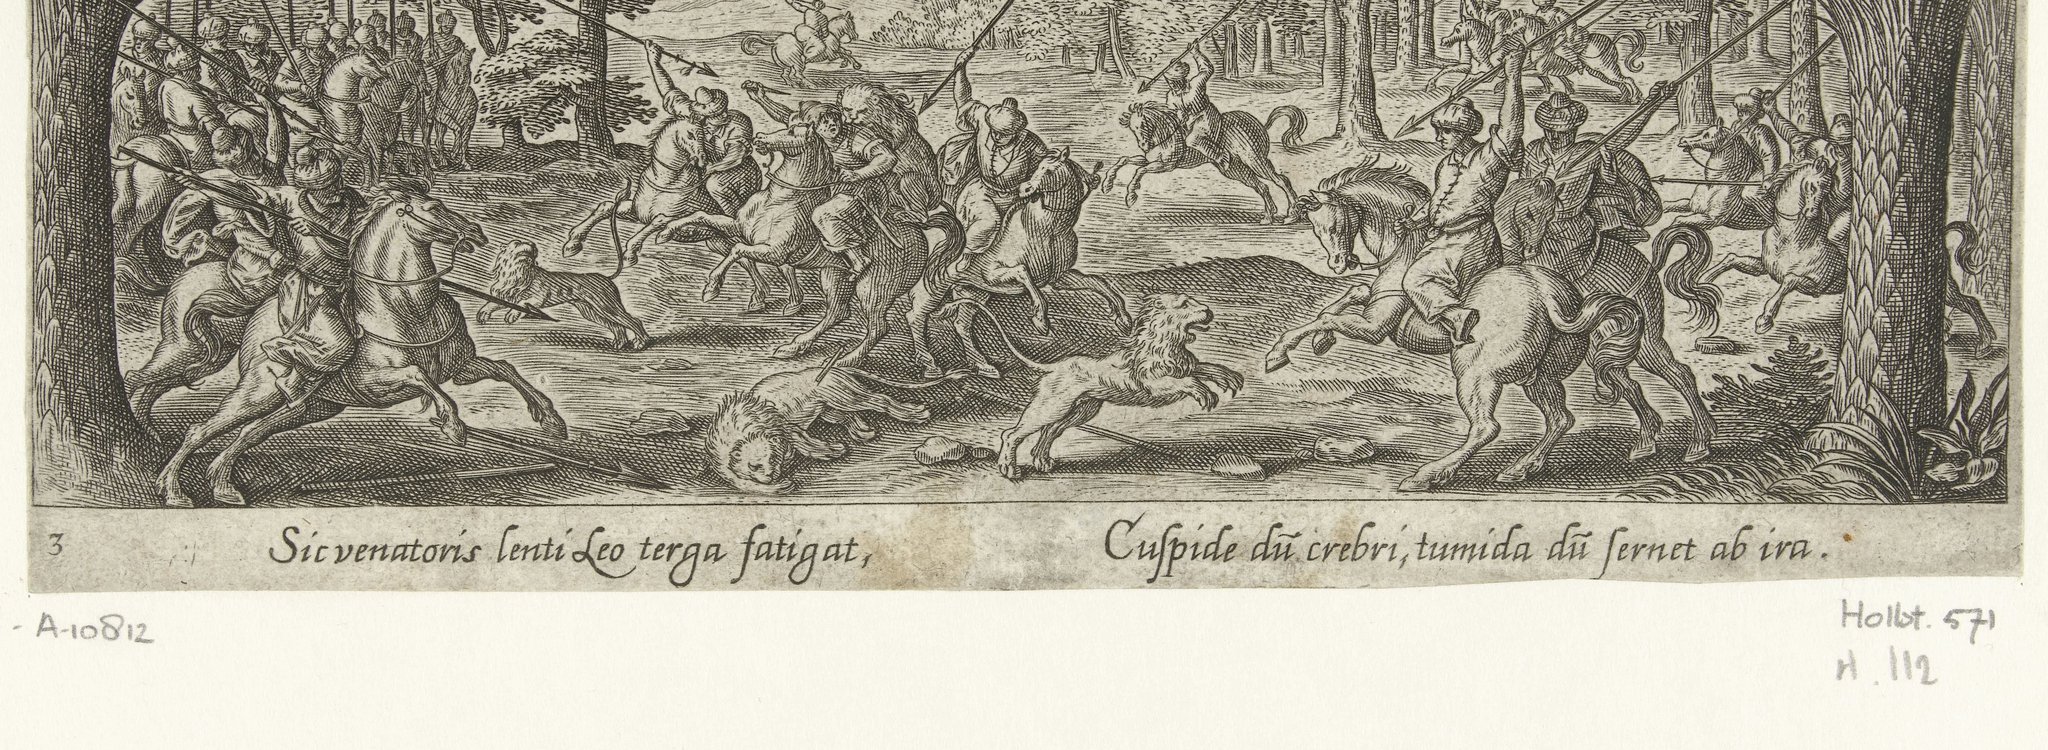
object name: print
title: Leeuwenjacht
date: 1582-1636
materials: paper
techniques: engraving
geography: antwerp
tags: lion hunt (+ hunting with horses)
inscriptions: collector's mark: Lugt 2228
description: Ruiters jagen op een groep leeuwen met speren. De prent heeft een Latijns onderschrift en maakt deel uit van een serie van 54 prenten.